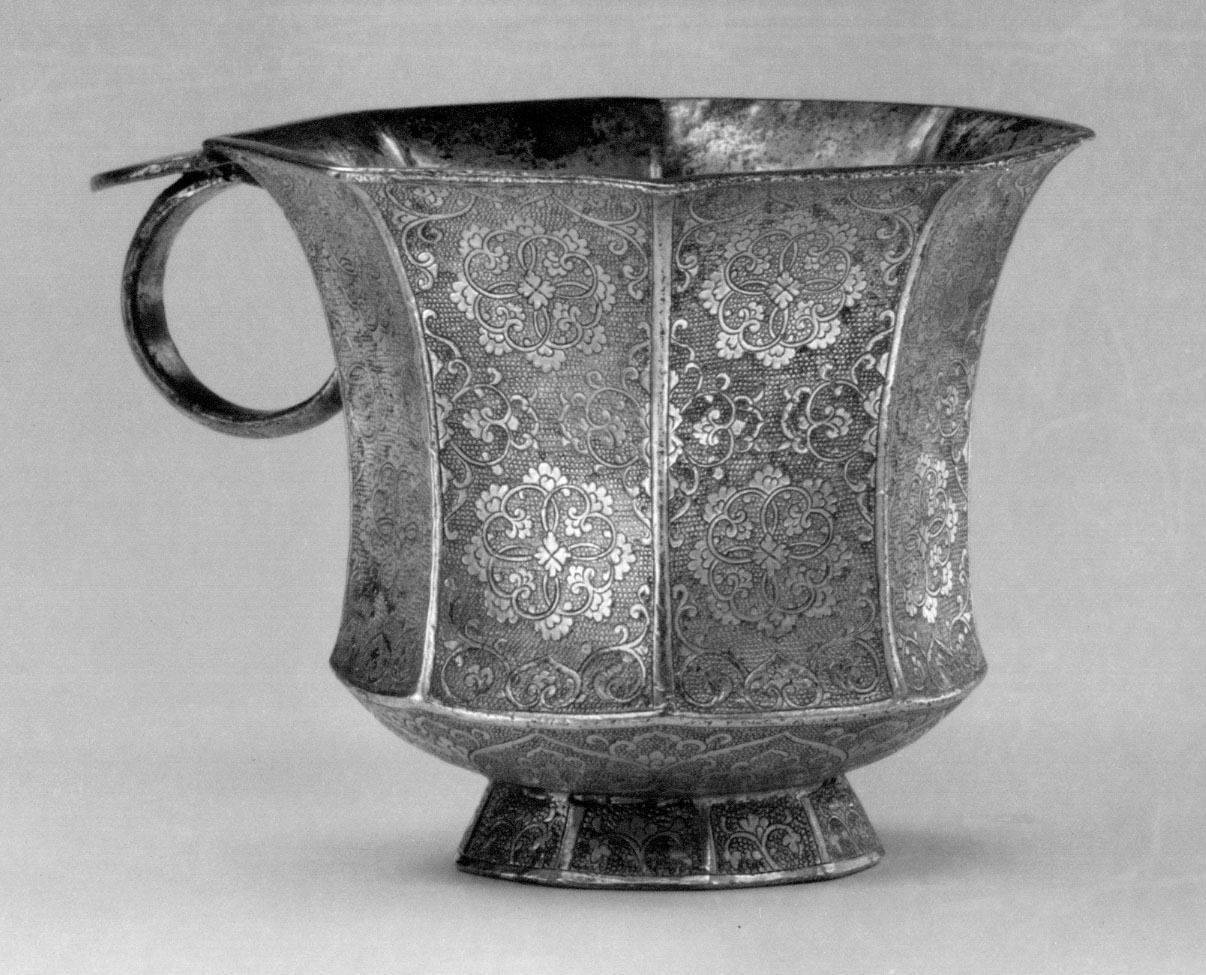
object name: cup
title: Octagonal cup with ring handle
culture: chinese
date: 701-800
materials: silver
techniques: gilding